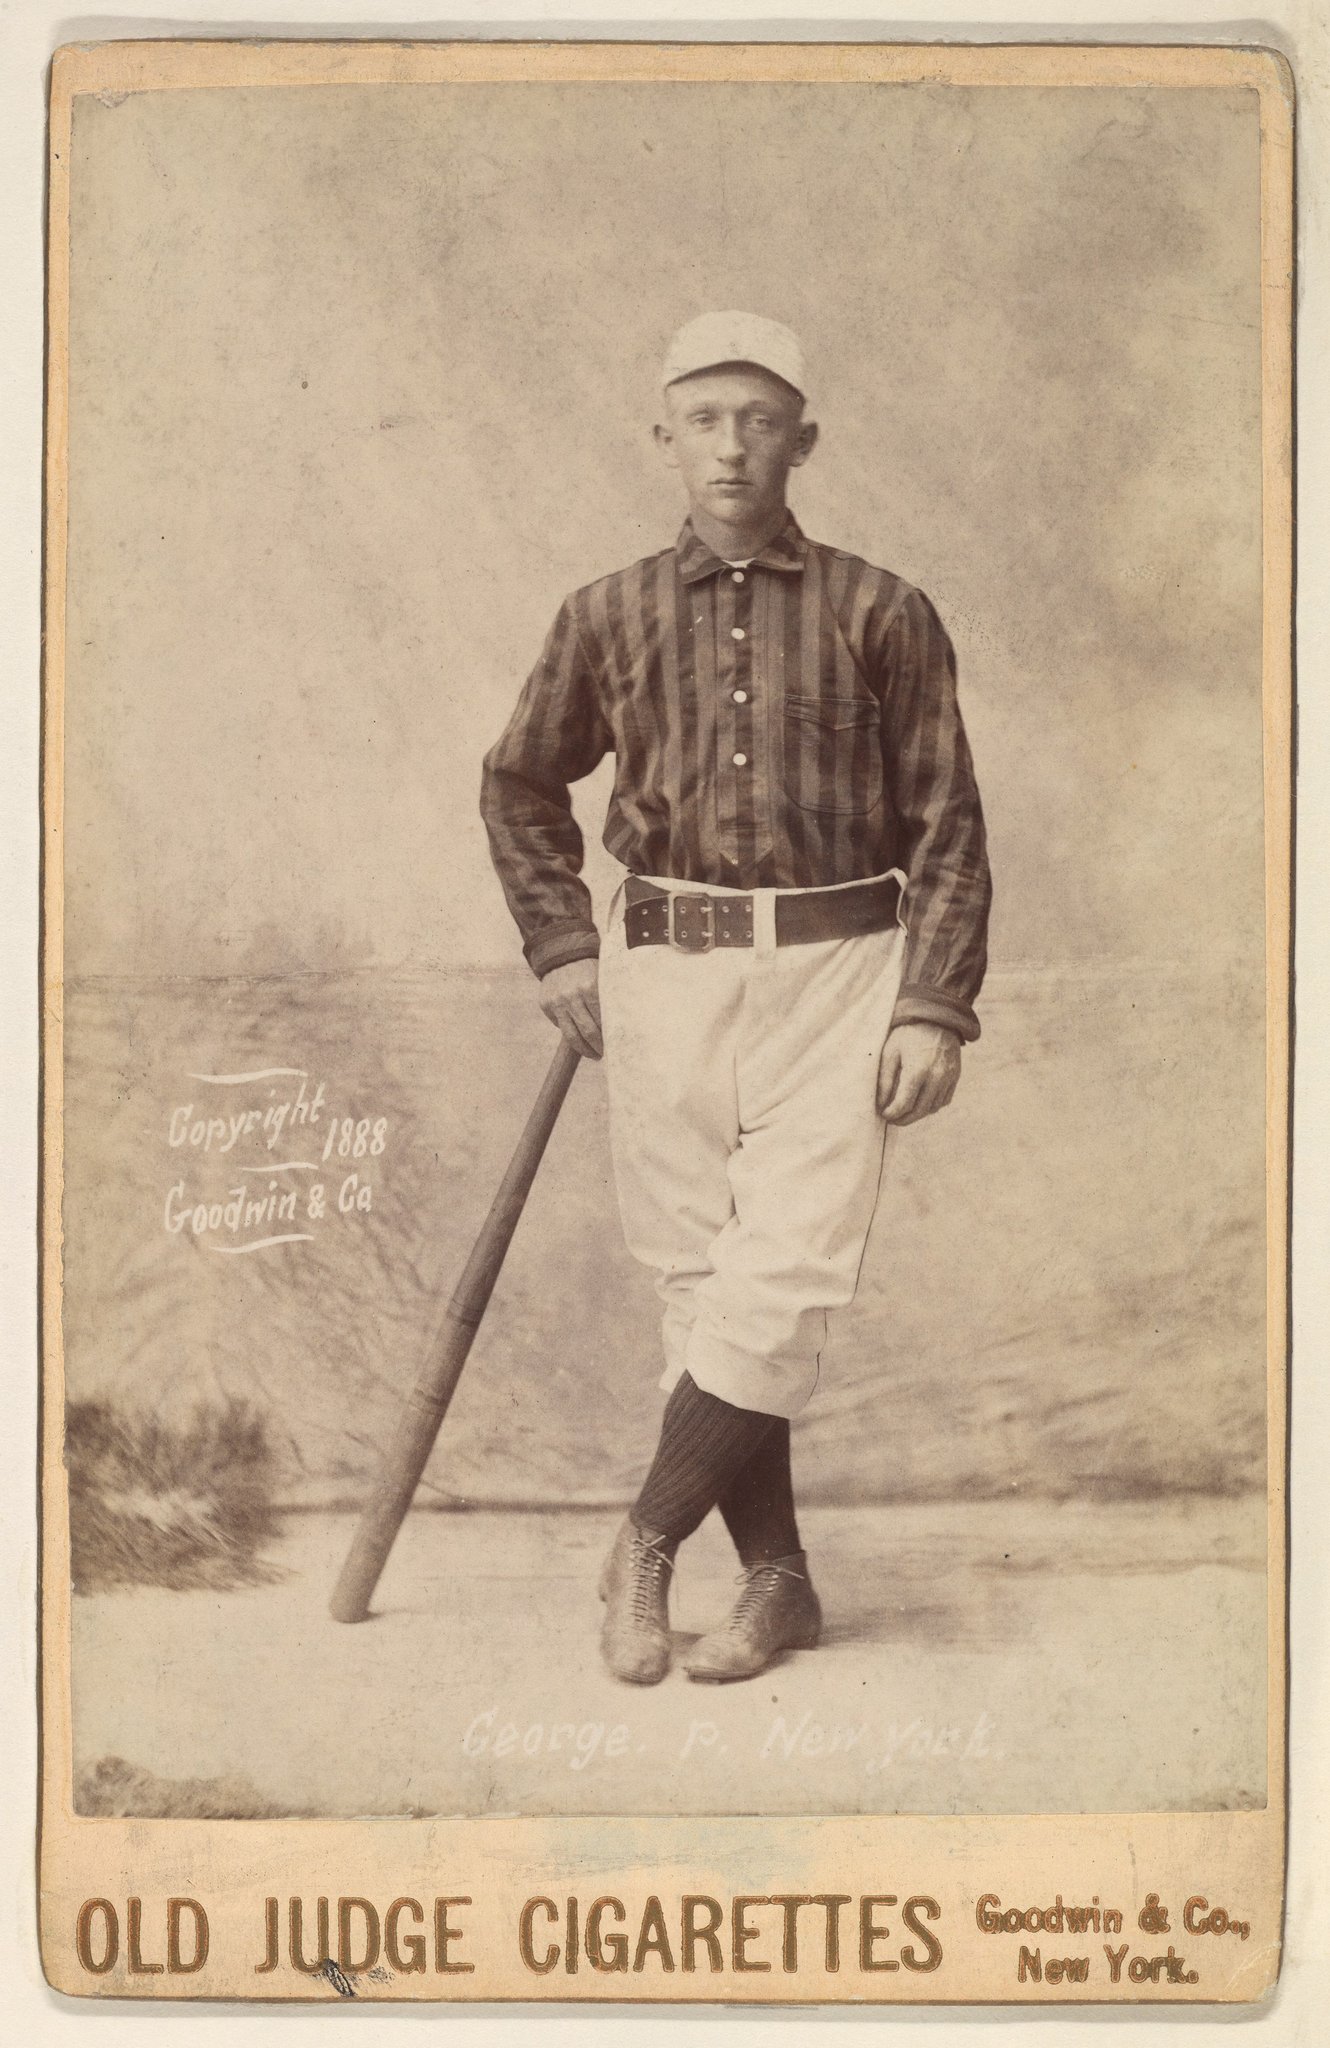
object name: baseball card, photograph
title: George, Pitcher, New York, from the series Old Judge Cigarettes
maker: goodwin & company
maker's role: publisher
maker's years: 1850-1950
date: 1888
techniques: albumen silver print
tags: men,portraits,baseball,athletes